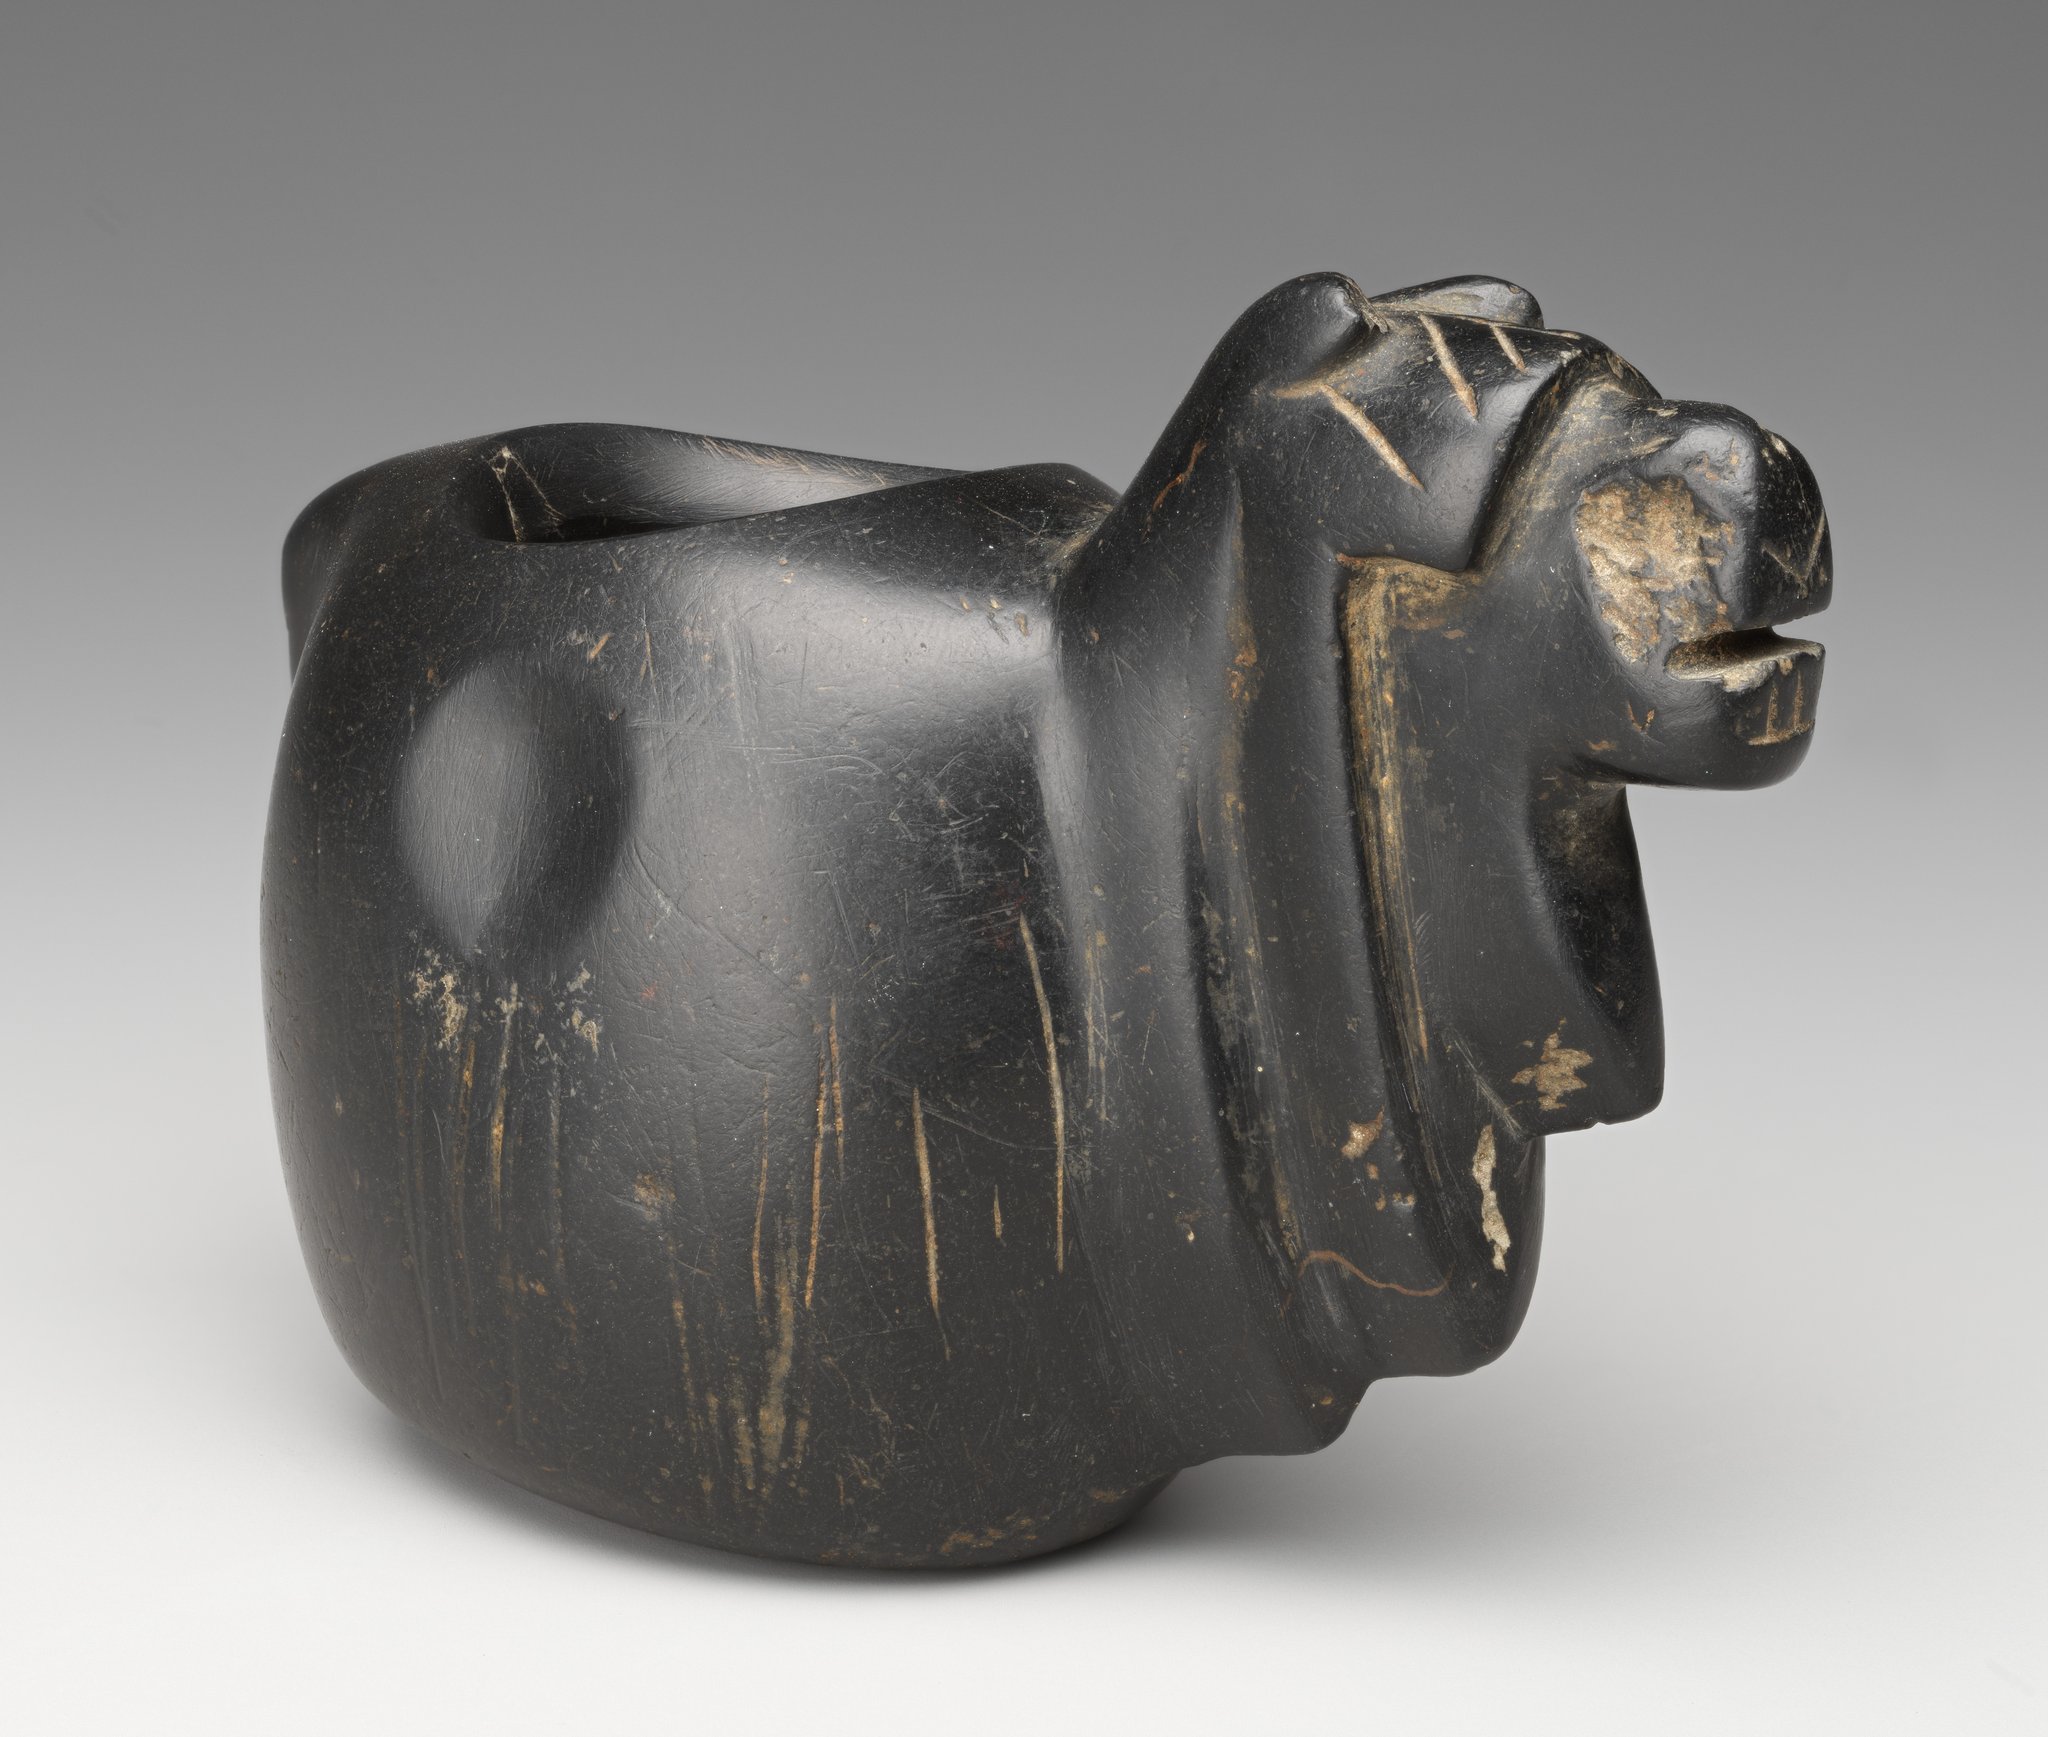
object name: container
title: Conopa (votive effigy)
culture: inca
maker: inca artist(s)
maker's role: artist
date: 1400-1535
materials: stone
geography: peru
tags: animals